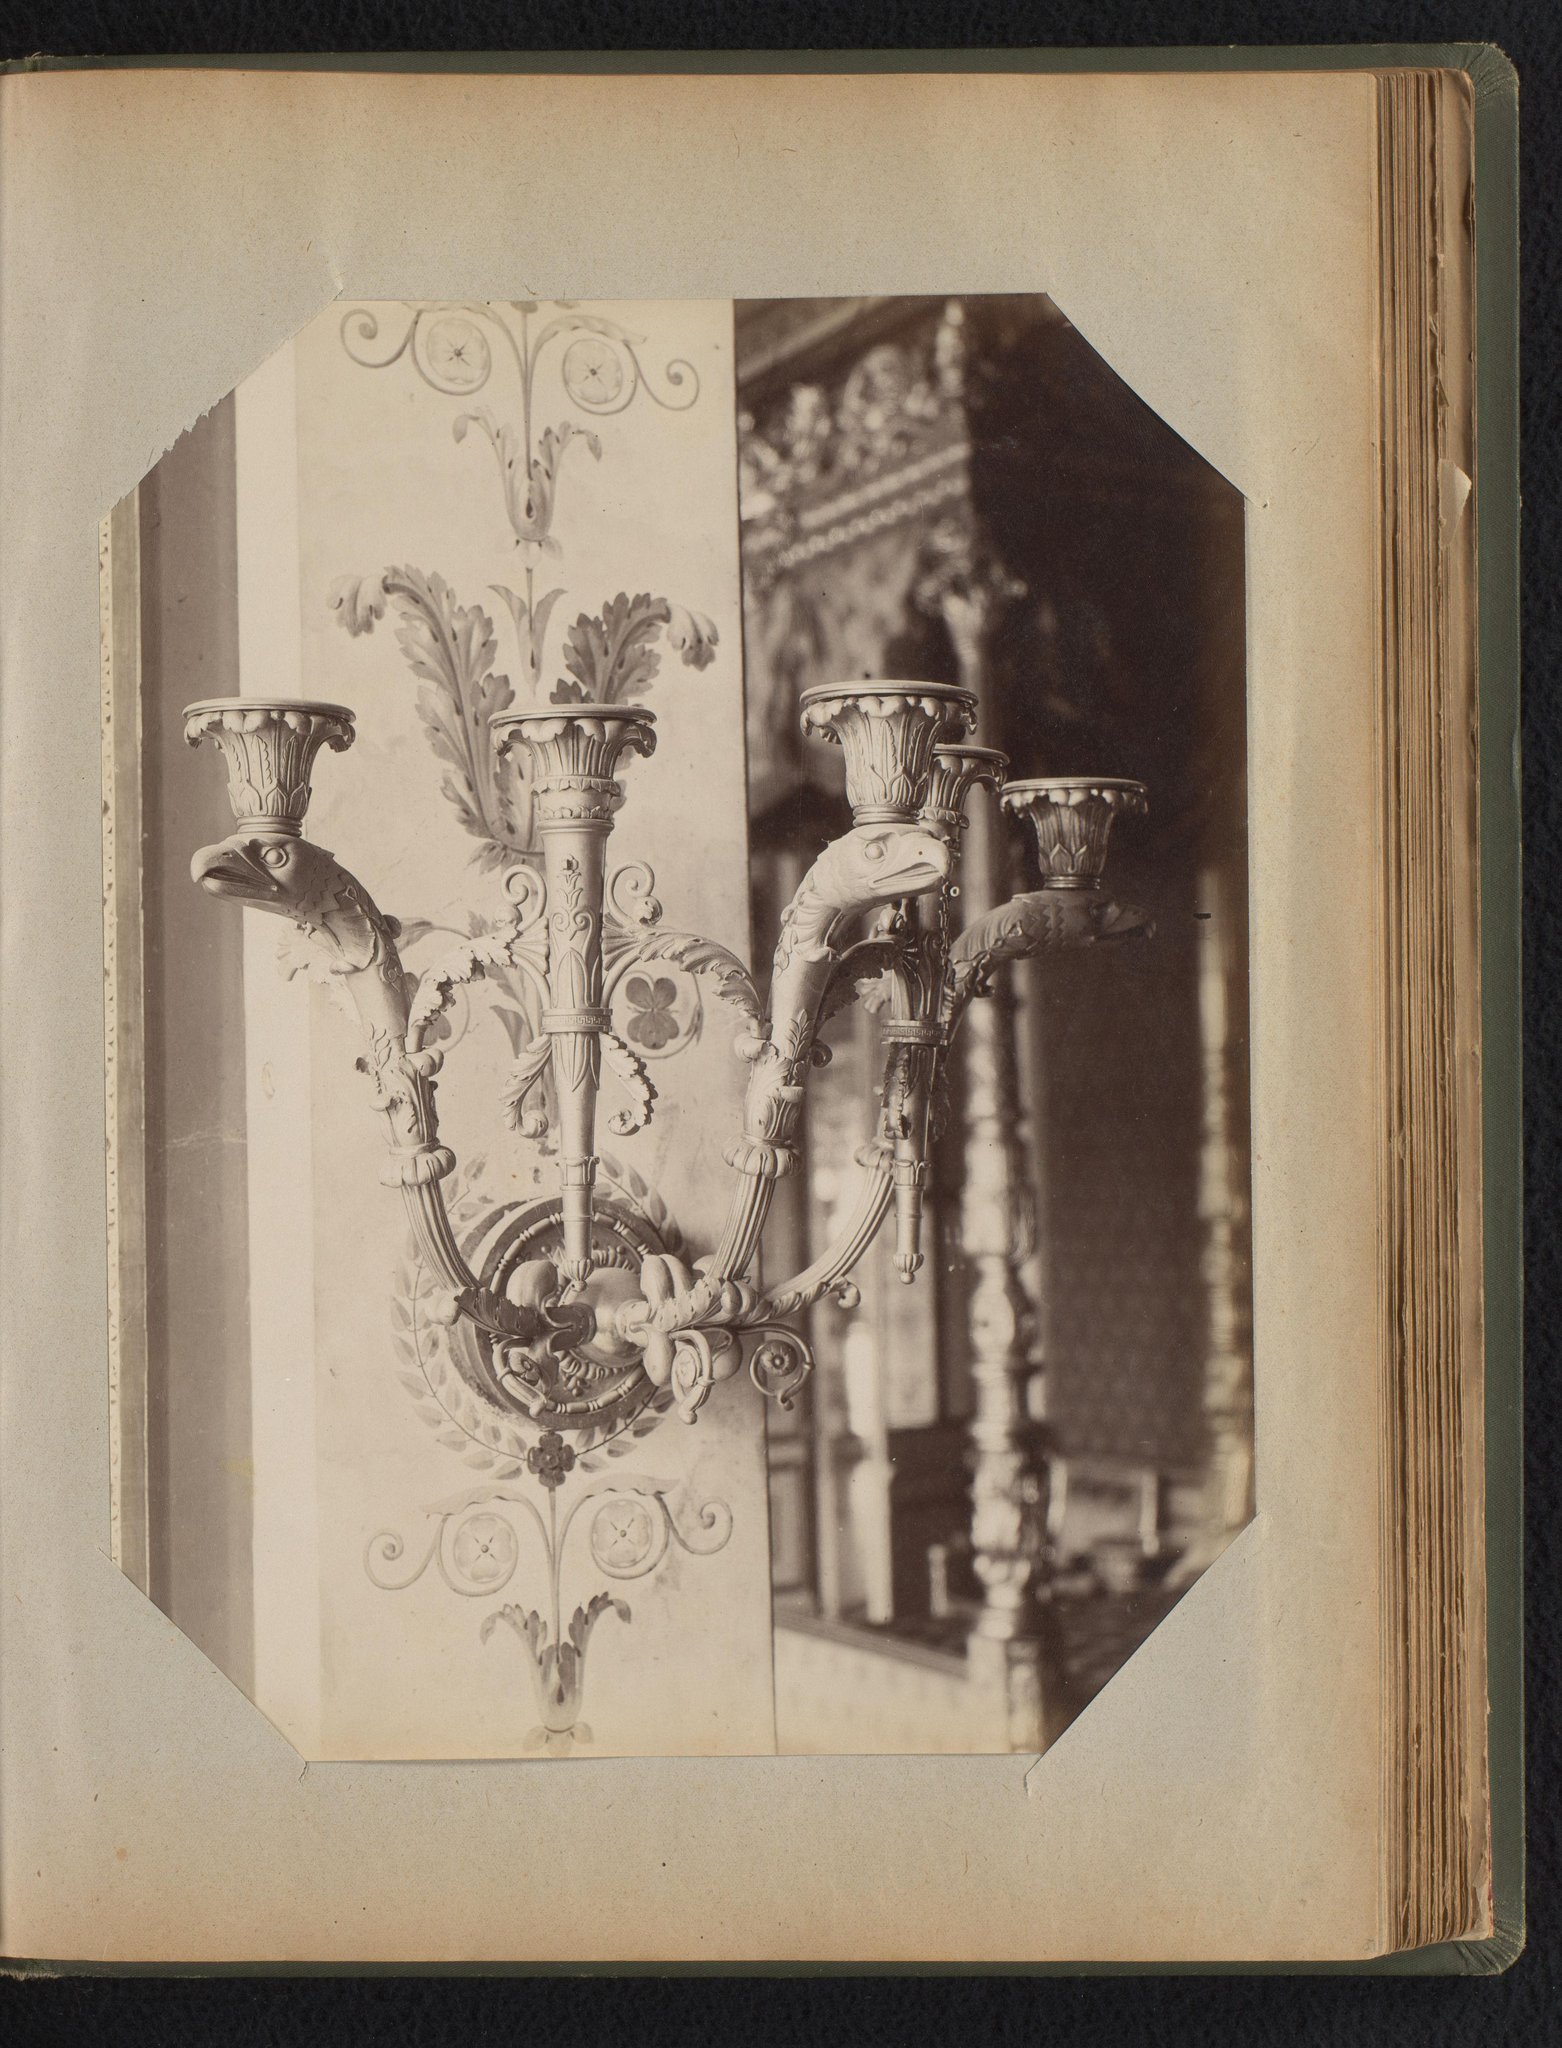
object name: photograph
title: Bronzen vijfarmige muurkandelaar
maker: Anonymous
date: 1860-1900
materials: paper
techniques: albumen print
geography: france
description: Waarvan drie van de kandelaars bestaan uit bronzen adelaarskoppen en twee uit bronzen fakkels. Onderdeel van een serie met betrekking tot het interieur van het paleis van Versailles met kroonluchters, deuren, portalen en meubelstukken.